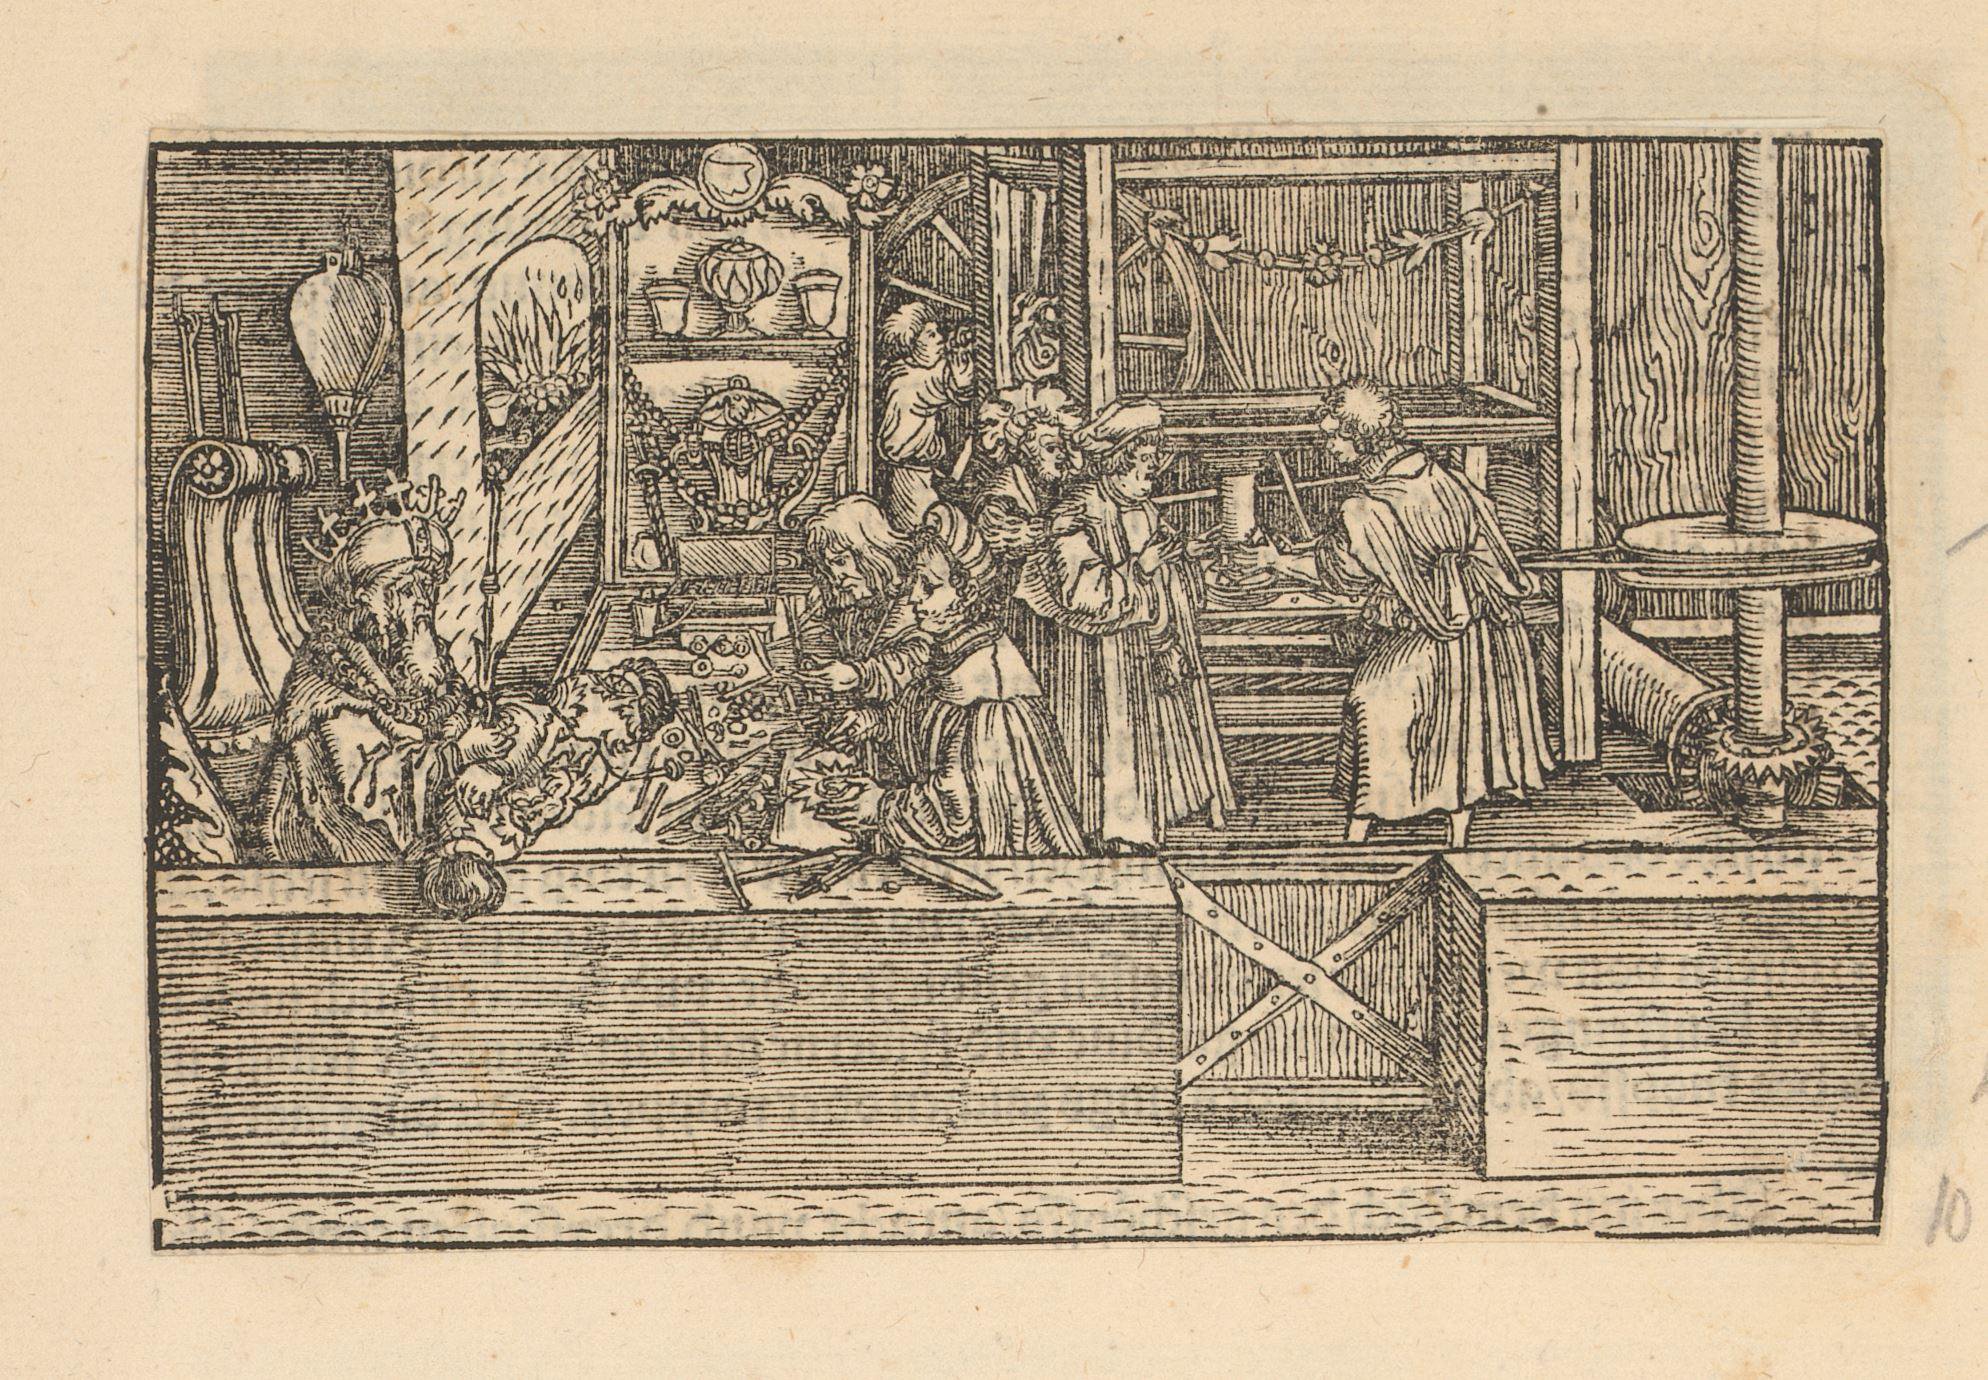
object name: print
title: Smederij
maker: Anonymous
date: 1514-1532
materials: paper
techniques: letterpress printing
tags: stone-cutter, stone-sawyer, smith, blacksmith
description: Deze prent is gebruikt in: Petrarca, Francesco. Von der Artzney bayder Glück, des guten und widerwertigen: unnd weß sich ain yeder inn Gelück und Unglück halten sol (...). Augsburg: Heinrich Steiner, 1532. Deze uitgave is ook bekend onder de titel 'Trostspiegel in Glück und Unglück'.